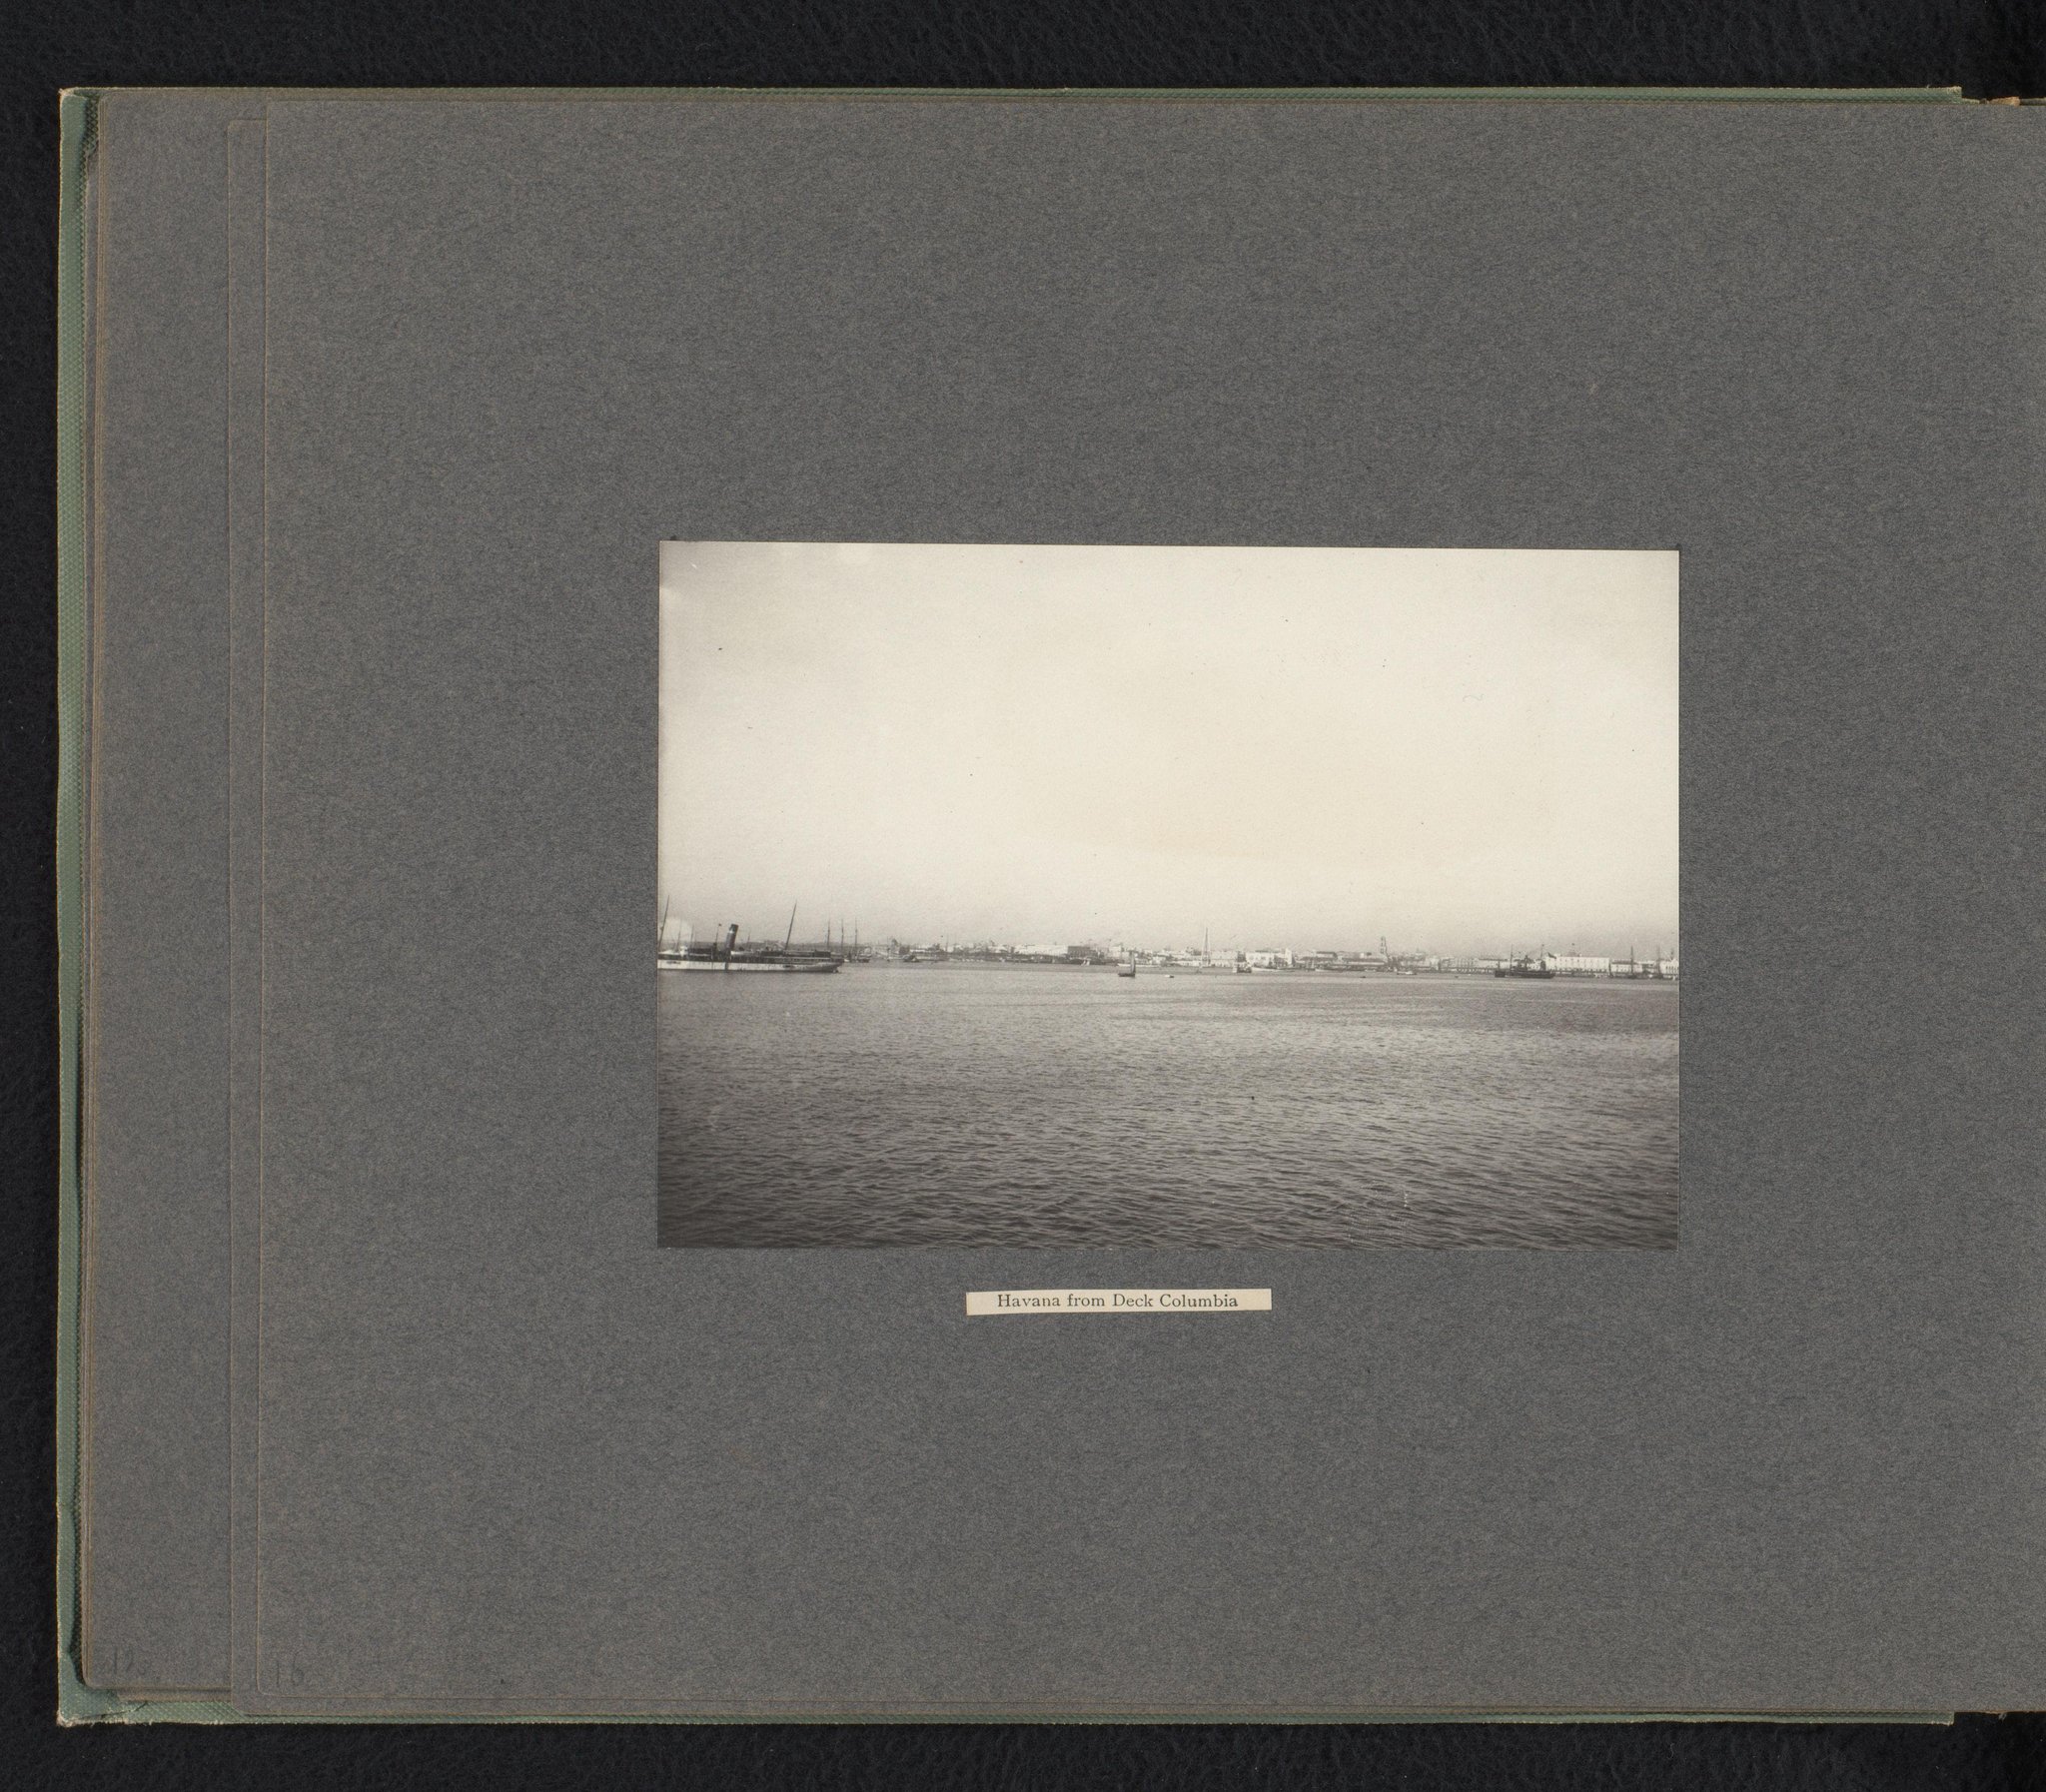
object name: photograph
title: Havana from Deck Columbia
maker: Anonymous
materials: paper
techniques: platinum process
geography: havana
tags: harbour, prospect of city, town panorama, silhouette of city